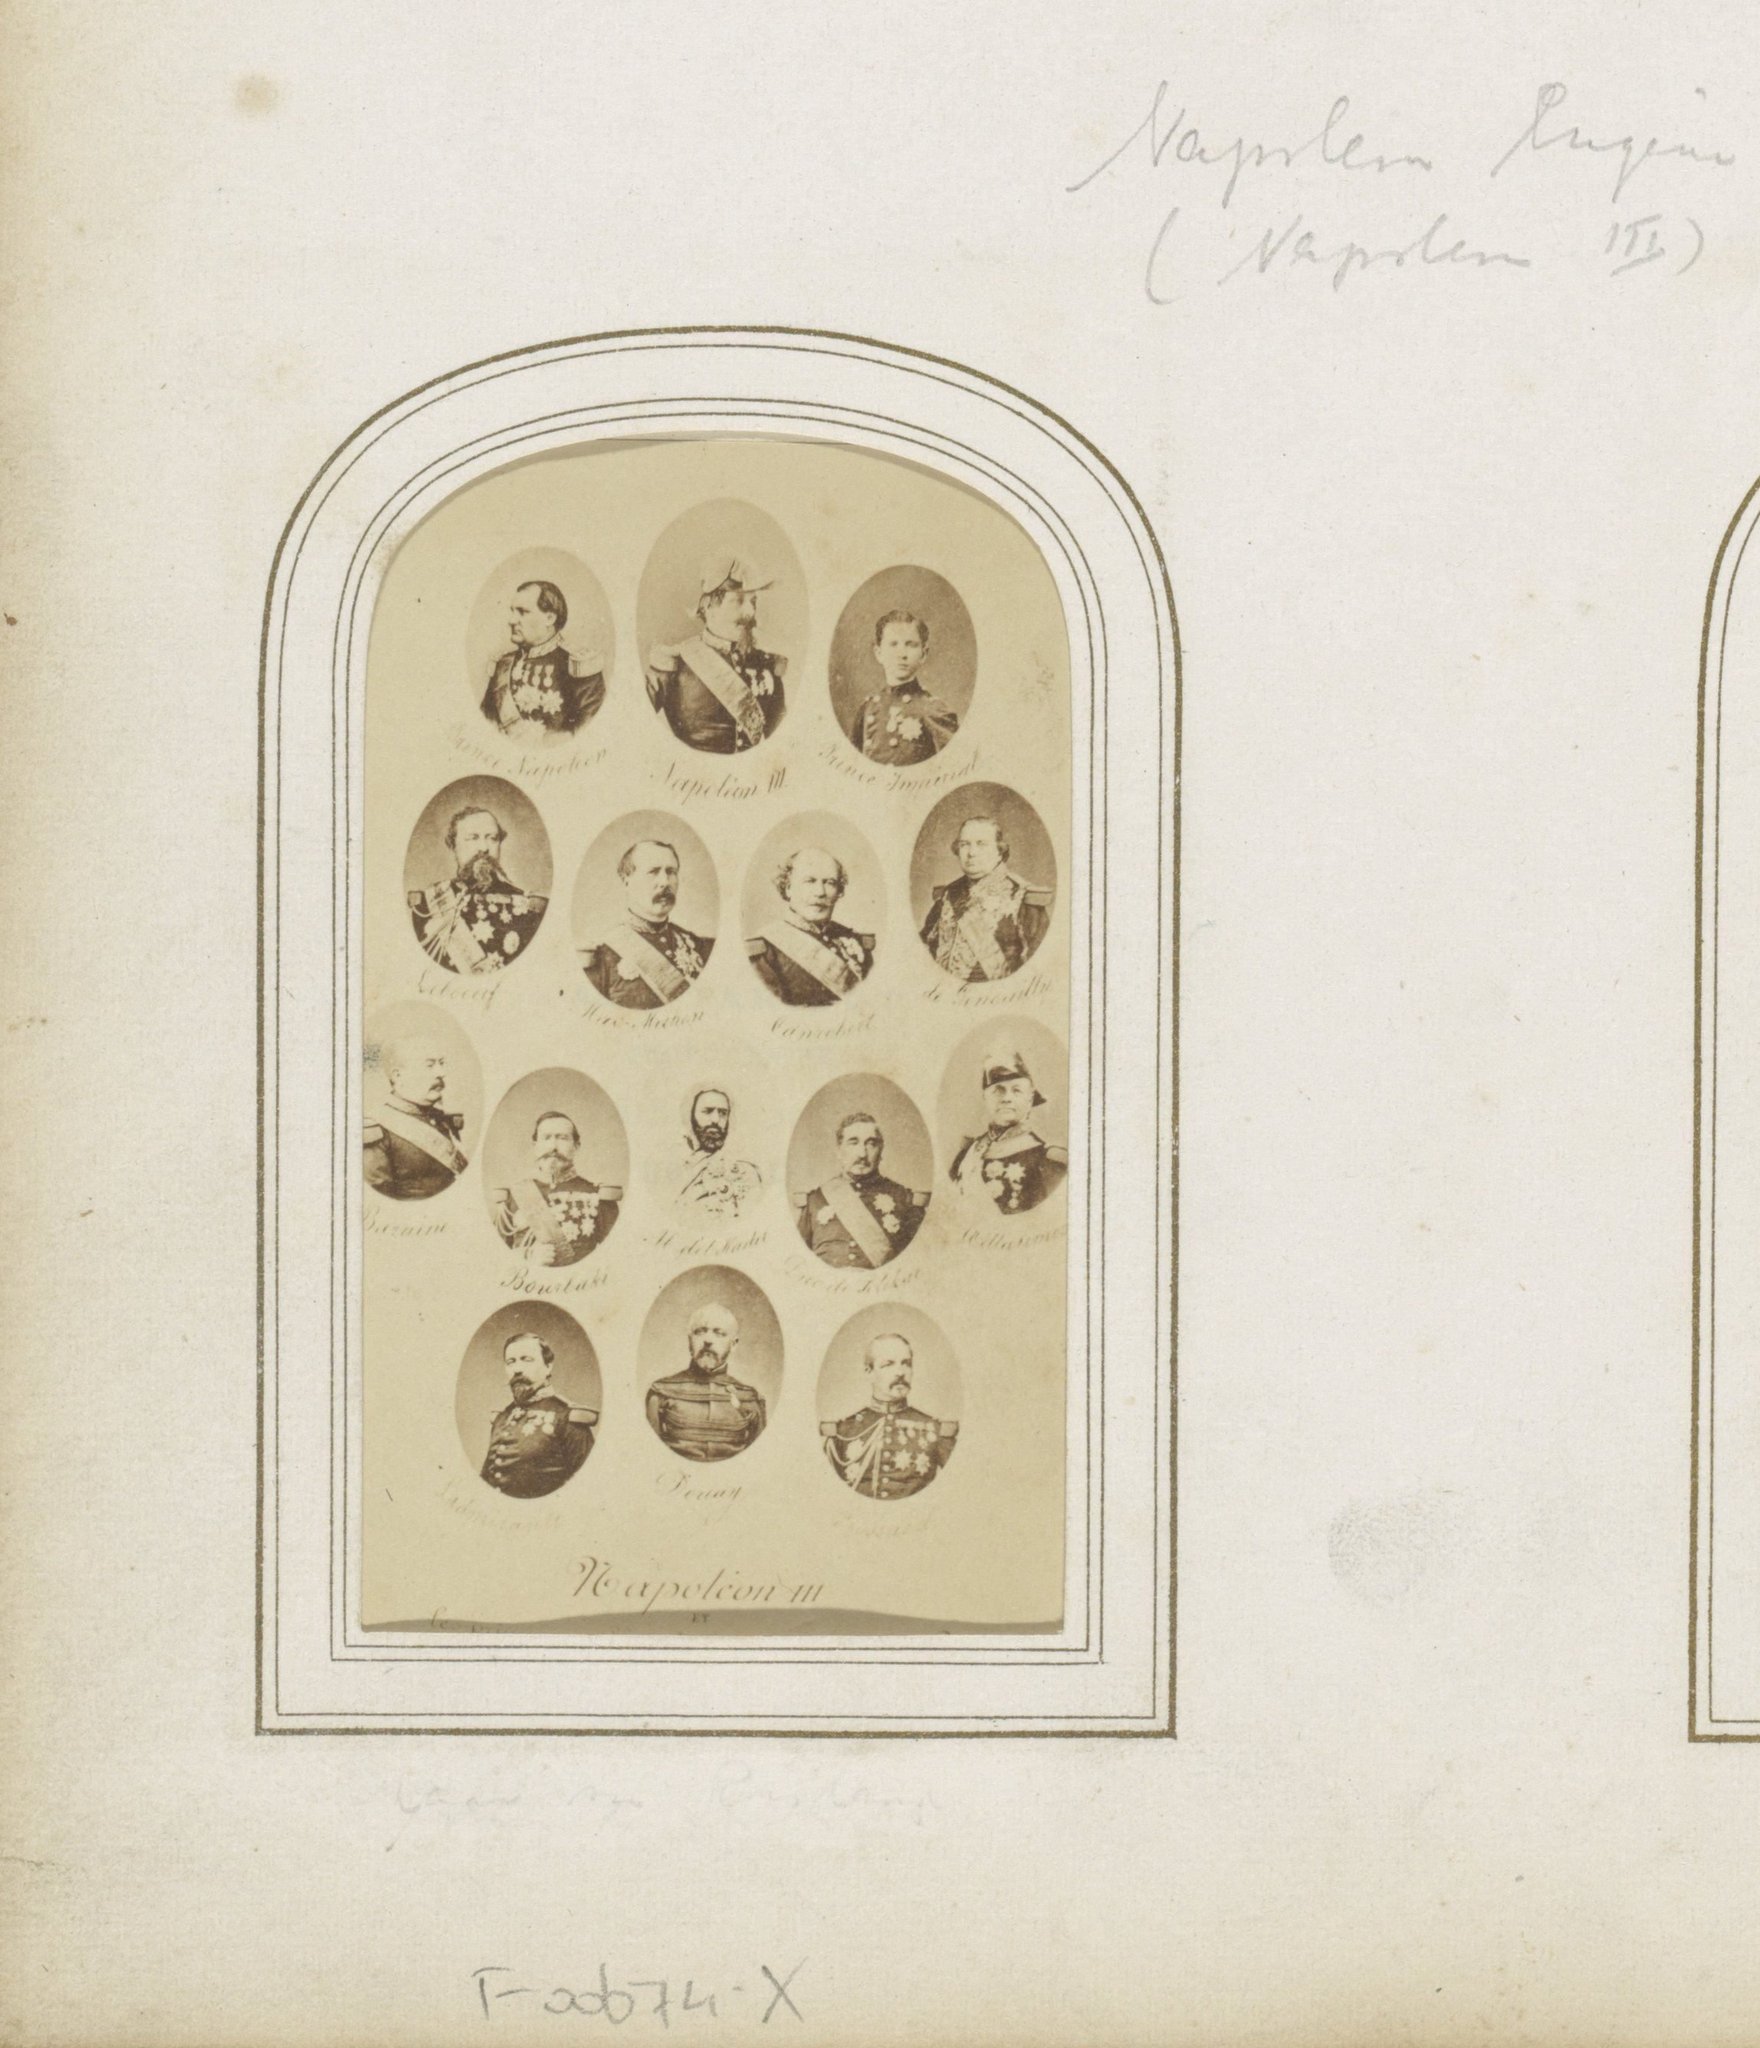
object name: carte de visite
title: Napoleon III et les principaux Chefs de l'armée française 1870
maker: Anonymous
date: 1870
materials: cardboard, paper, photographic support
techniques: albumen print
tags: paris, london, napoleon iii (keizer der fransen), historical persons, medals and other marks of military honour, (military) uniforms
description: Onderdeel van Fotoalbum met 123 cartes-de-visite van leden van Europese vorstenhuizen, politici en bekende personen.